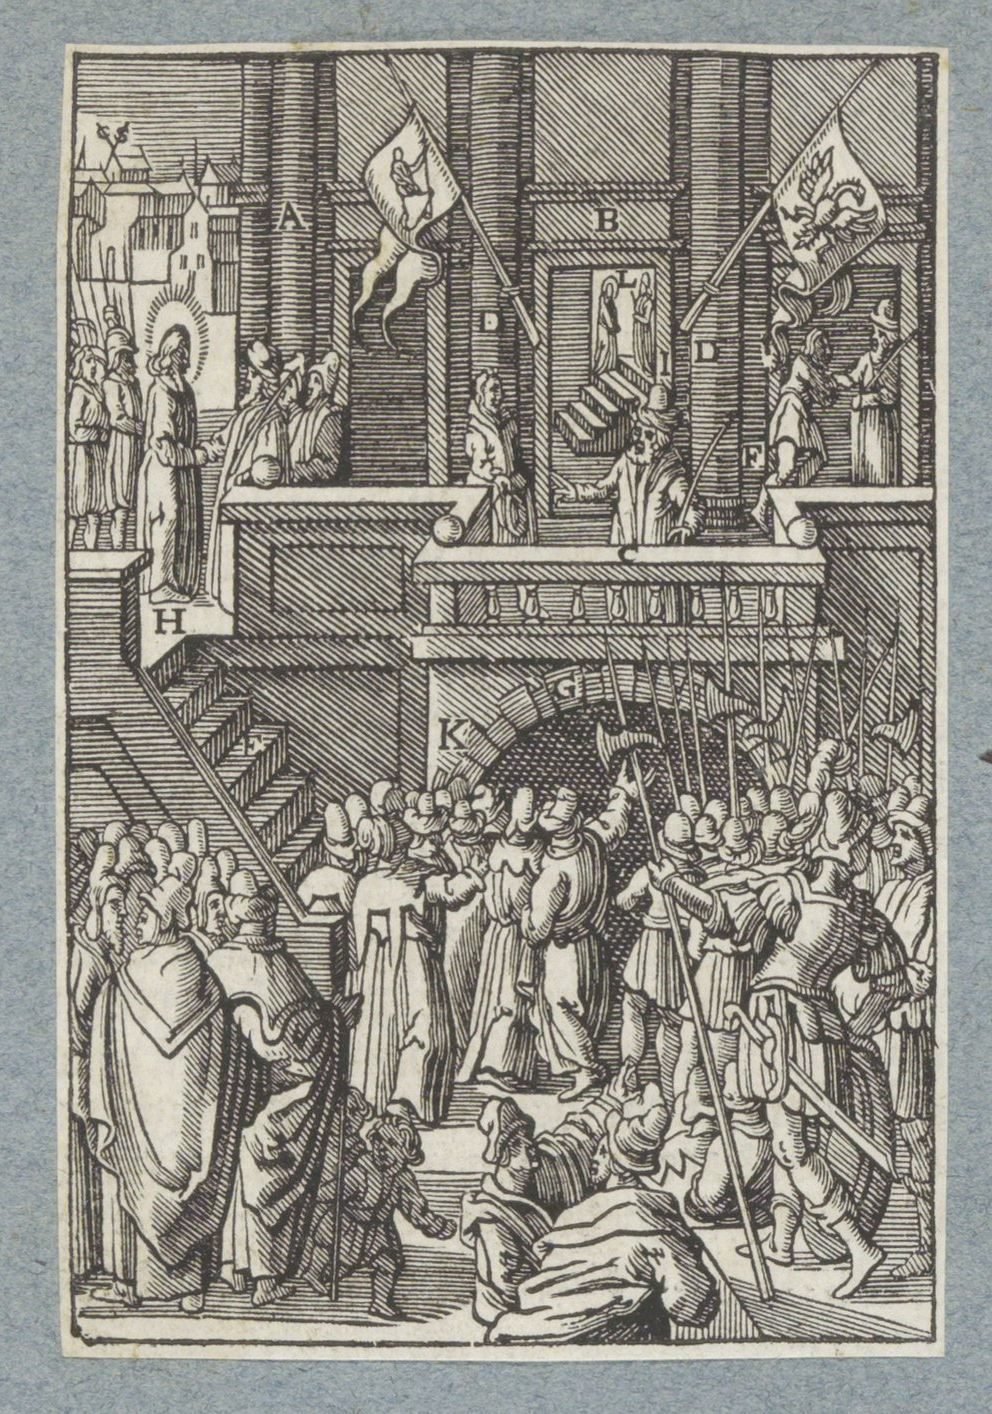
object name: book illustration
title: Christus voor Pilatus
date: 1629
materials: paper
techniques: letterpress printing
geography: antwerp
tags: christ before pontius pilate (matthew 27:11-26; mark 15:2-15; luke 23:2-7, 23:13-25; john 18:28 - 19:16), pilate in debate with the jews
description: De prent is afkomstig uit een van de uitgaven van P.J. Paets uit Amsterdam. De prent wordt voor het eerst gebruikt in: Der Zielen Lust-hof. Leuven, I.Jacbosz voor P.J. Paets [= Amsterdam, P.J. Paets], 1629. De voorstelling is gekopieerd naar een prent van Hieronymus Wierix voor: Nadal, Jerónimo. Evangelicae Historiae Imagines. Antwerpen, M. Nutius, 1593.